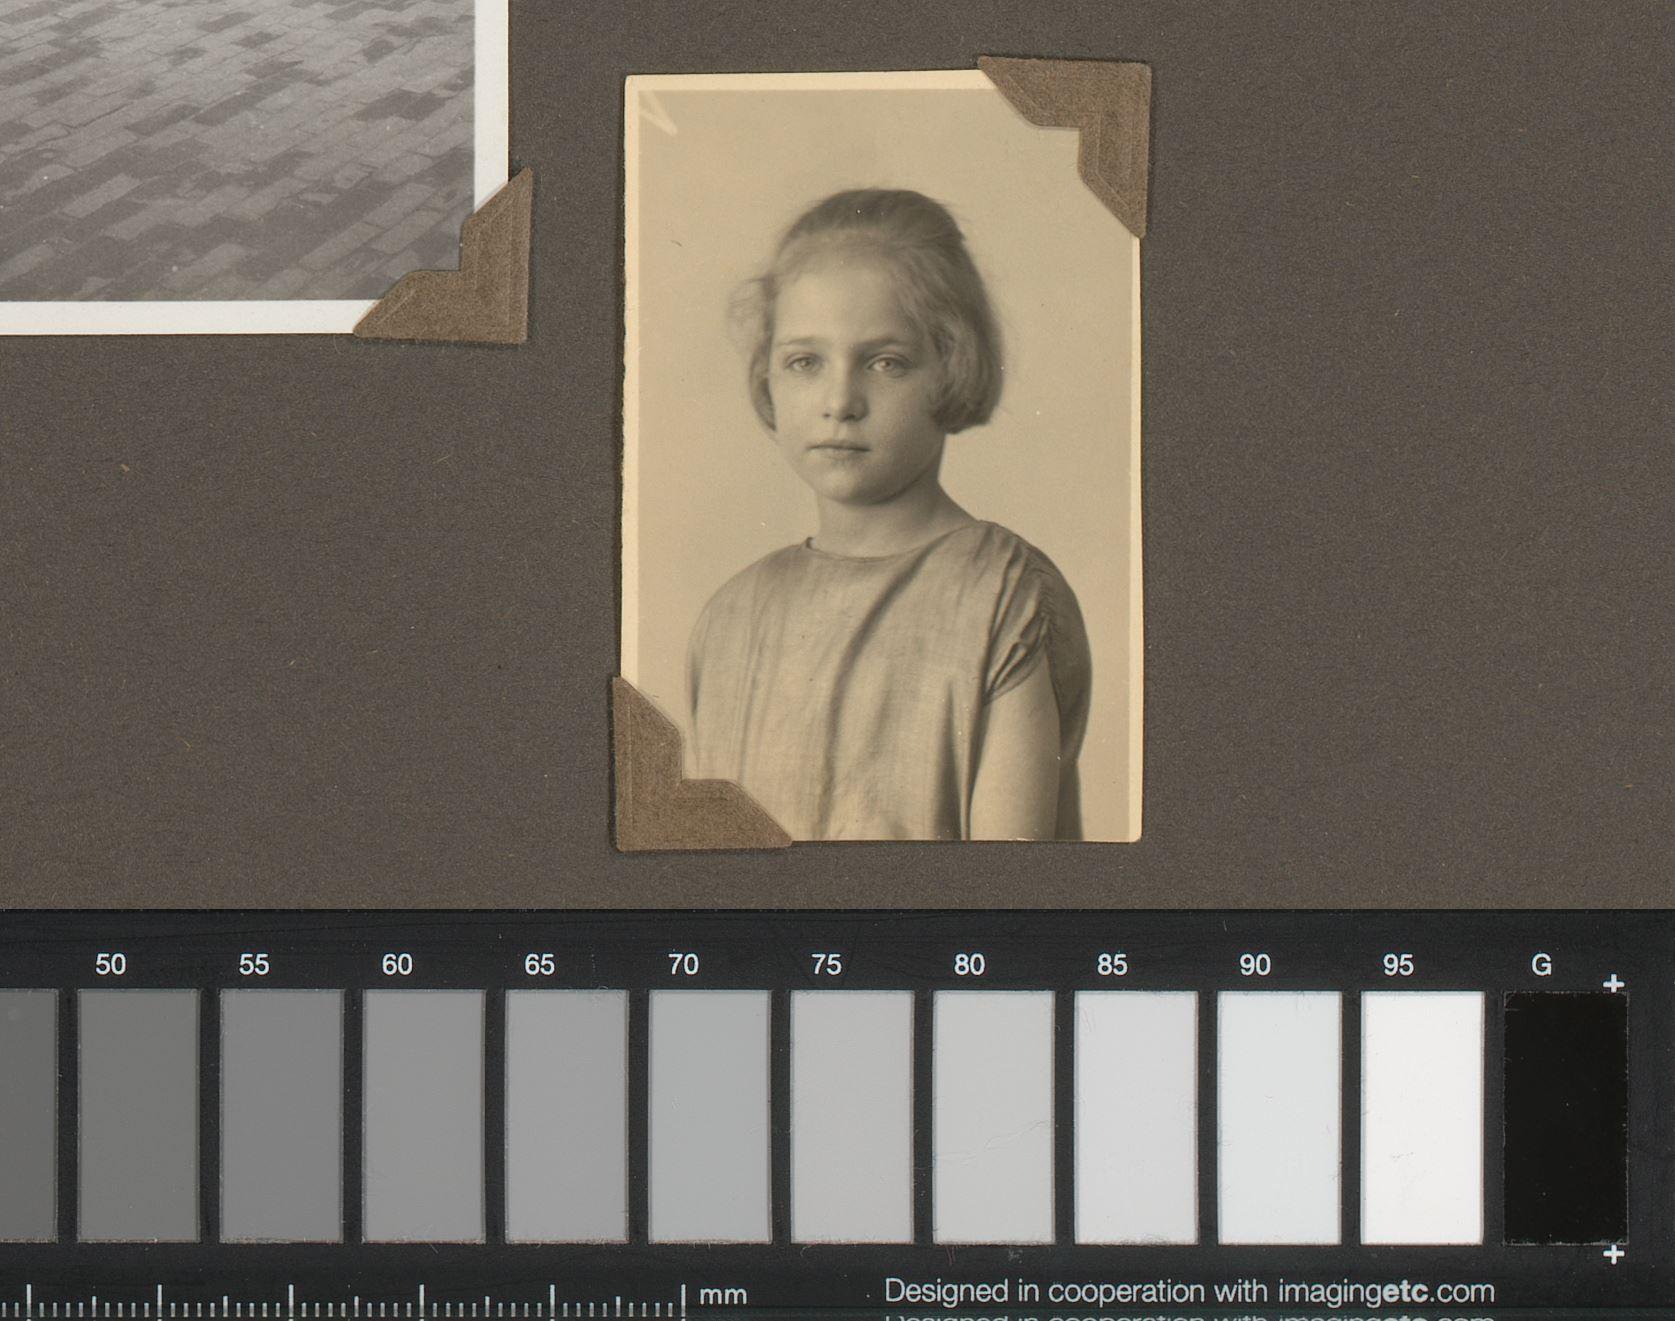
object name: photograph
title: Portret van een meisje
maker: Anonymous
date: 1920-1940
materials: photographic support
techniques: gelatin silver print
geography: netherlands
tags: historical persons, girl (child between toddler and youth)